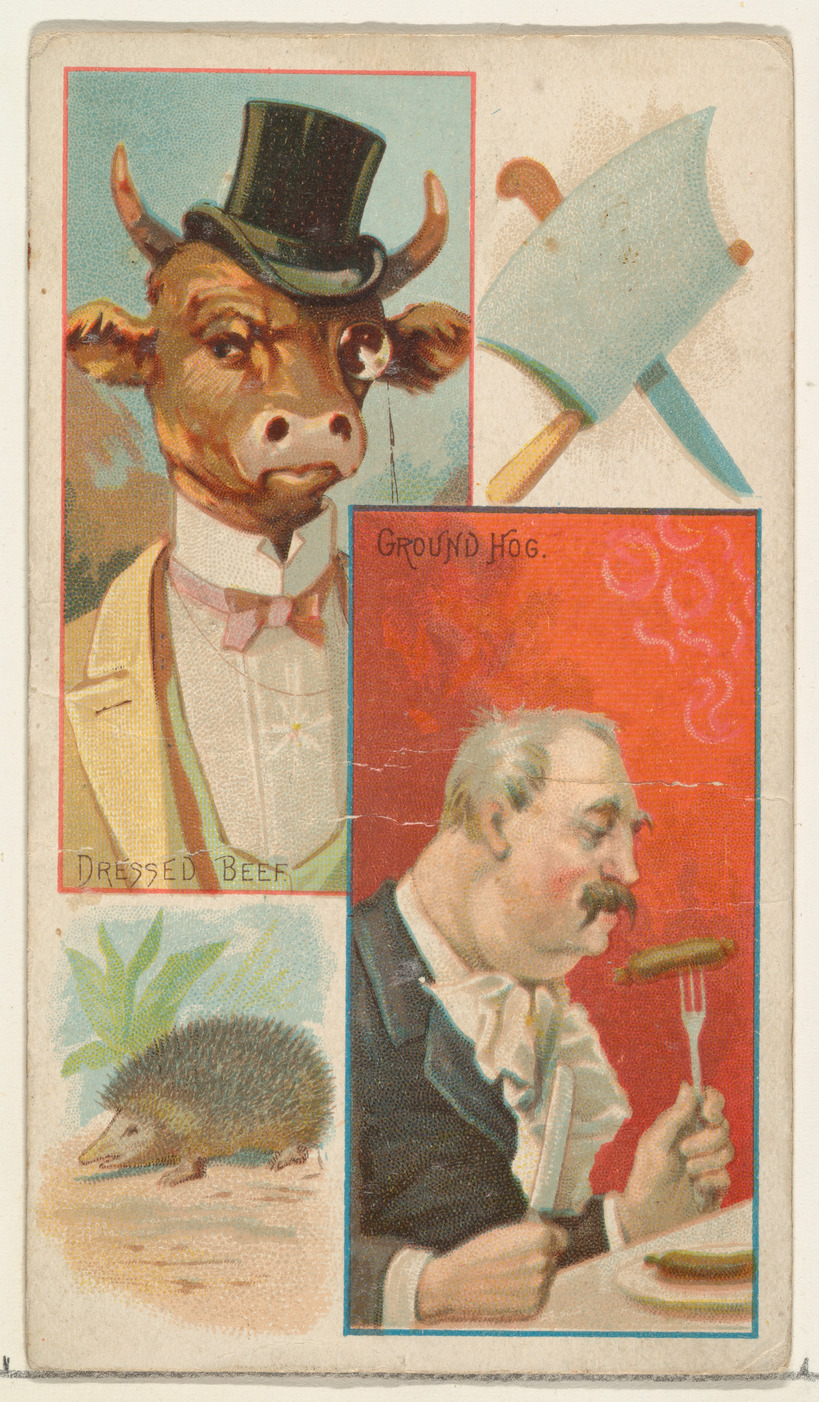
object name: print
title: Dressed Beef / Ground Hog, from the Jokes series (N118) issued by Duke Sons & Co. to promote Honest Long Cut Tobacco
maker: w. duke, sons & co.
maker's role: publisher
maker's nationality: american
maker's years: 1870-1920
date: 1891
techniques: color lithograph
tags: animals,men,axes